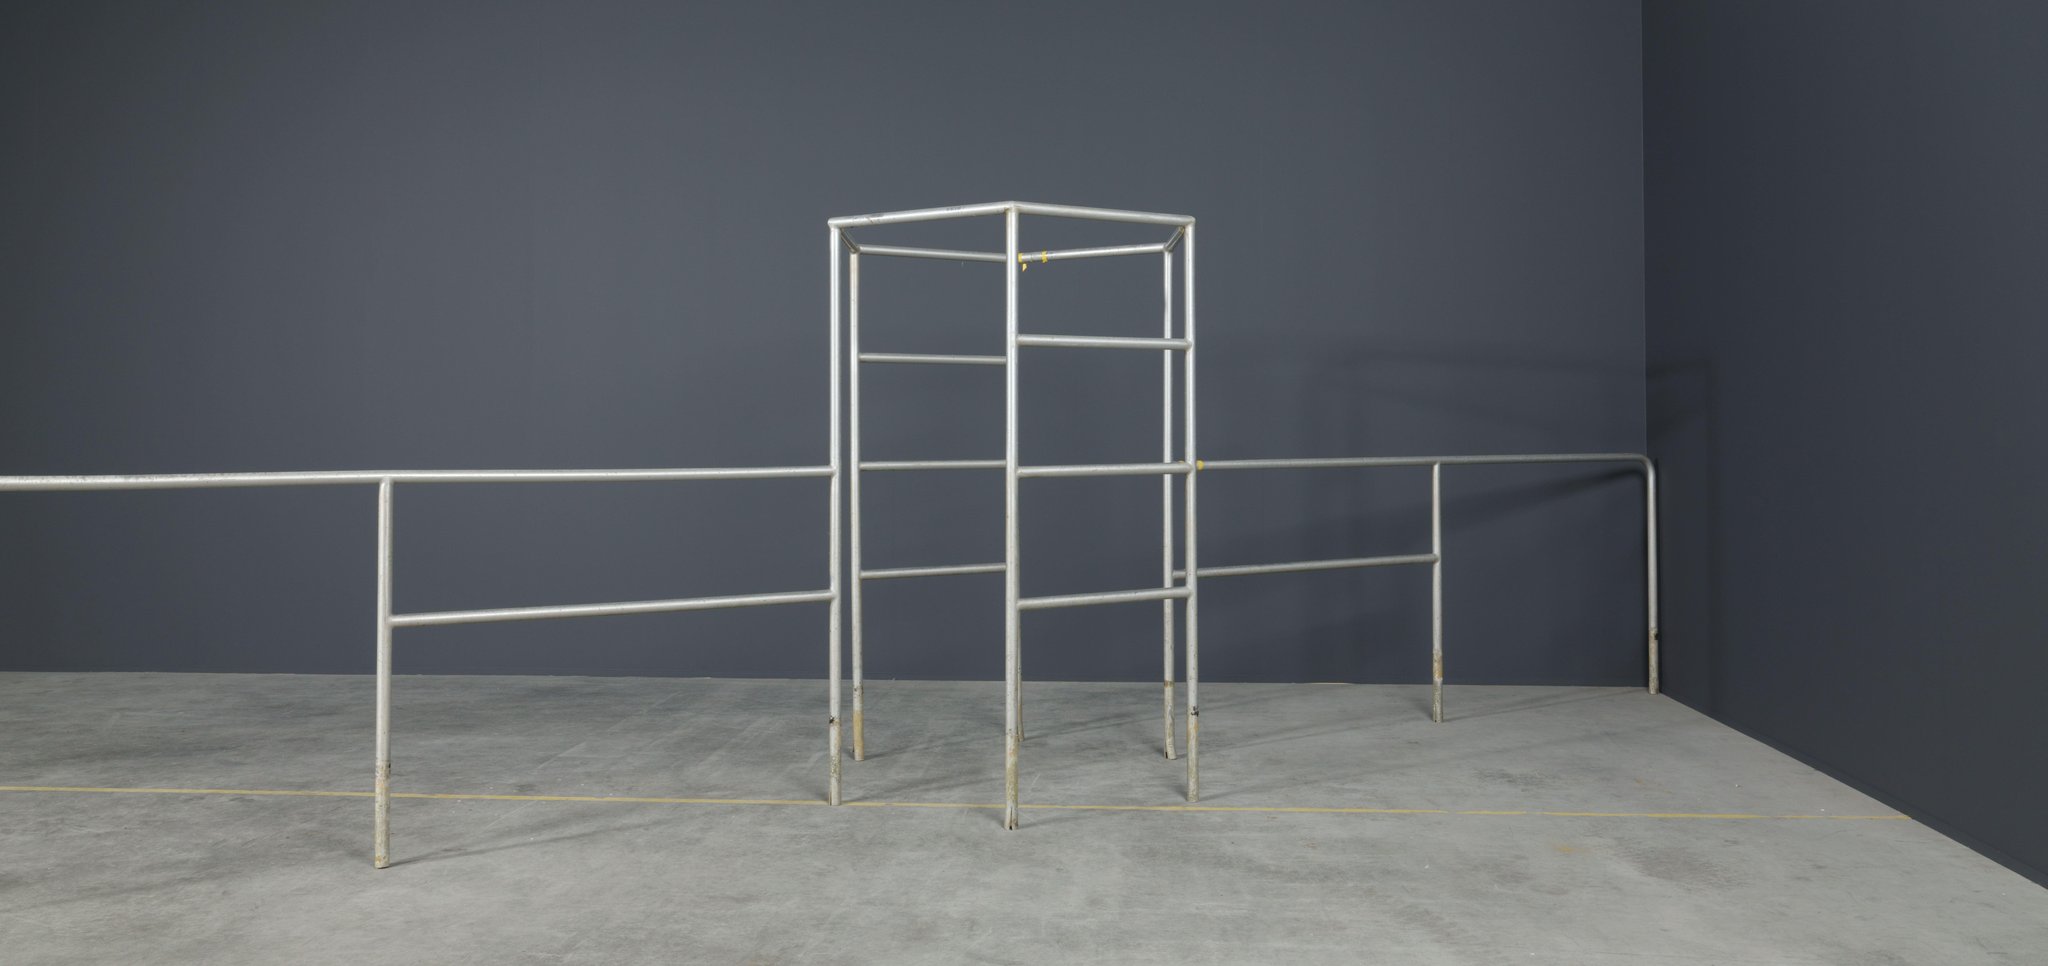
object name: speeltoestel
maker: aldo van eyck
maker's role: architect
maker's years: 1918-1999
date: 1962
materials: aluminum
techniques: welding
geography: kinderdijk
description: Aluminium buis, onderdeel van een speeltoestel.